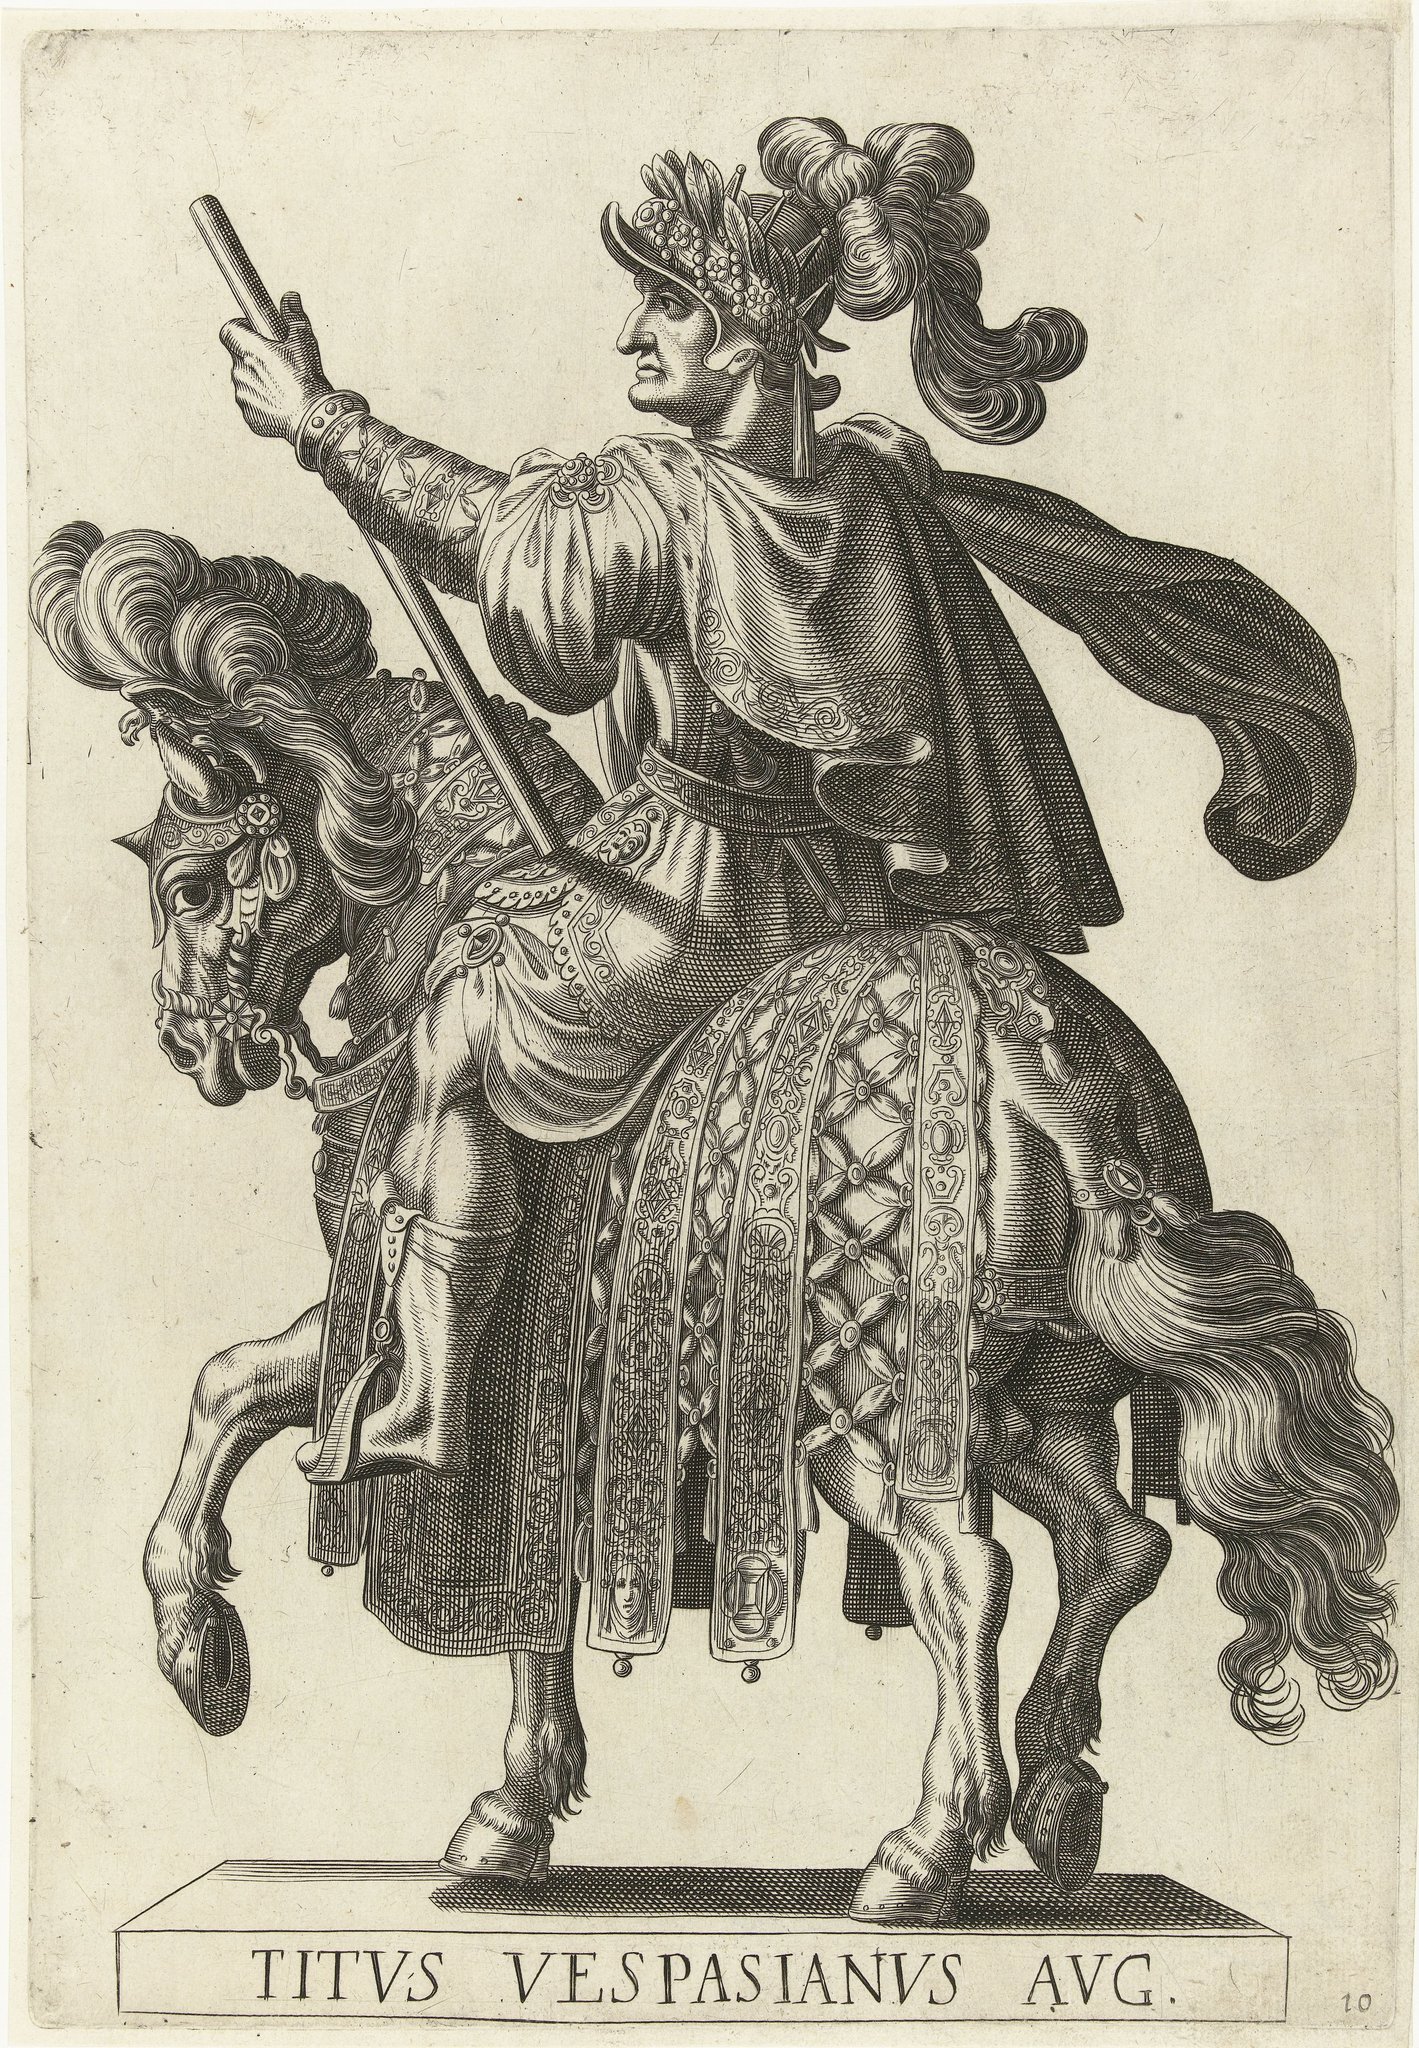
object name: print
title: Ruiterportret van keizer Titus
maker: laurens eillarts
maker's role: print maker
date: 1616-1618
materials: paper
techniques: engraving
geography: italy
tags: aquae cutiliae, keizer, titus (keizer van het romeinse rijk)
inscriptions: collector's mark: Lugt 2228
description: Keizer Titus te paard, op de rug gezien, met zijn commandostaf steunend op zijn bovenbeen.